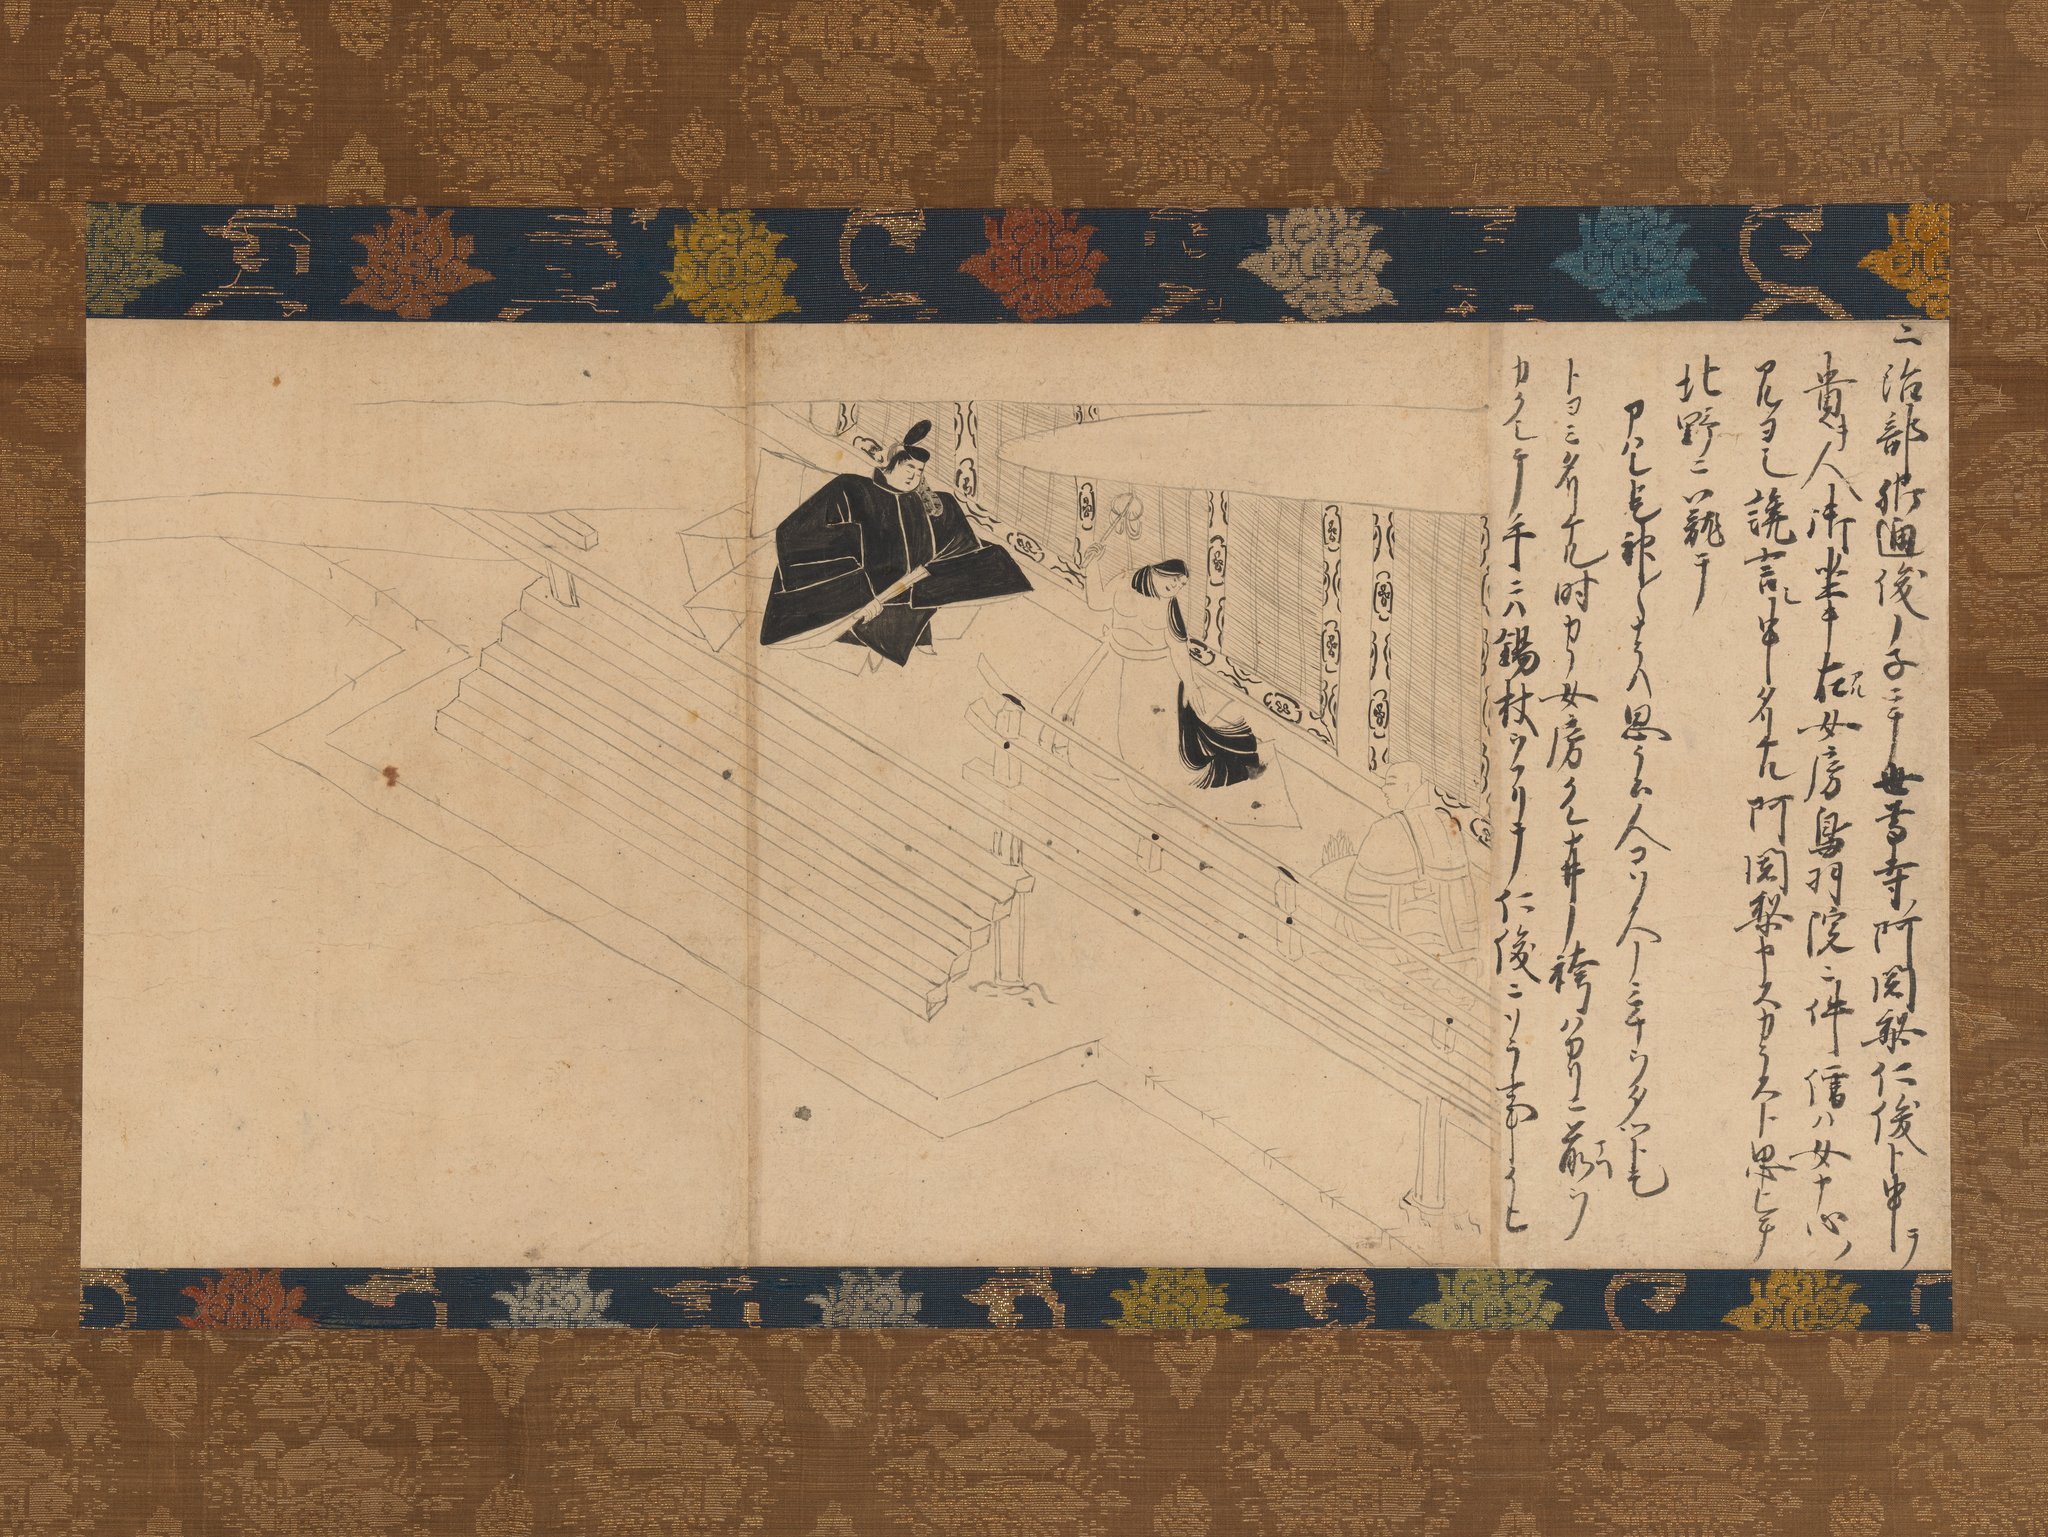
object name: hanging scroll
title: Possession of the Shamaness Tajihi no Ayako by the Spirit of Sugawara no Michizane, from Illustrated Legends of the Kitano Tenjin Shrine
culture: japanese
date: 1300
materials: ink, paper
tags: men,women,dancing